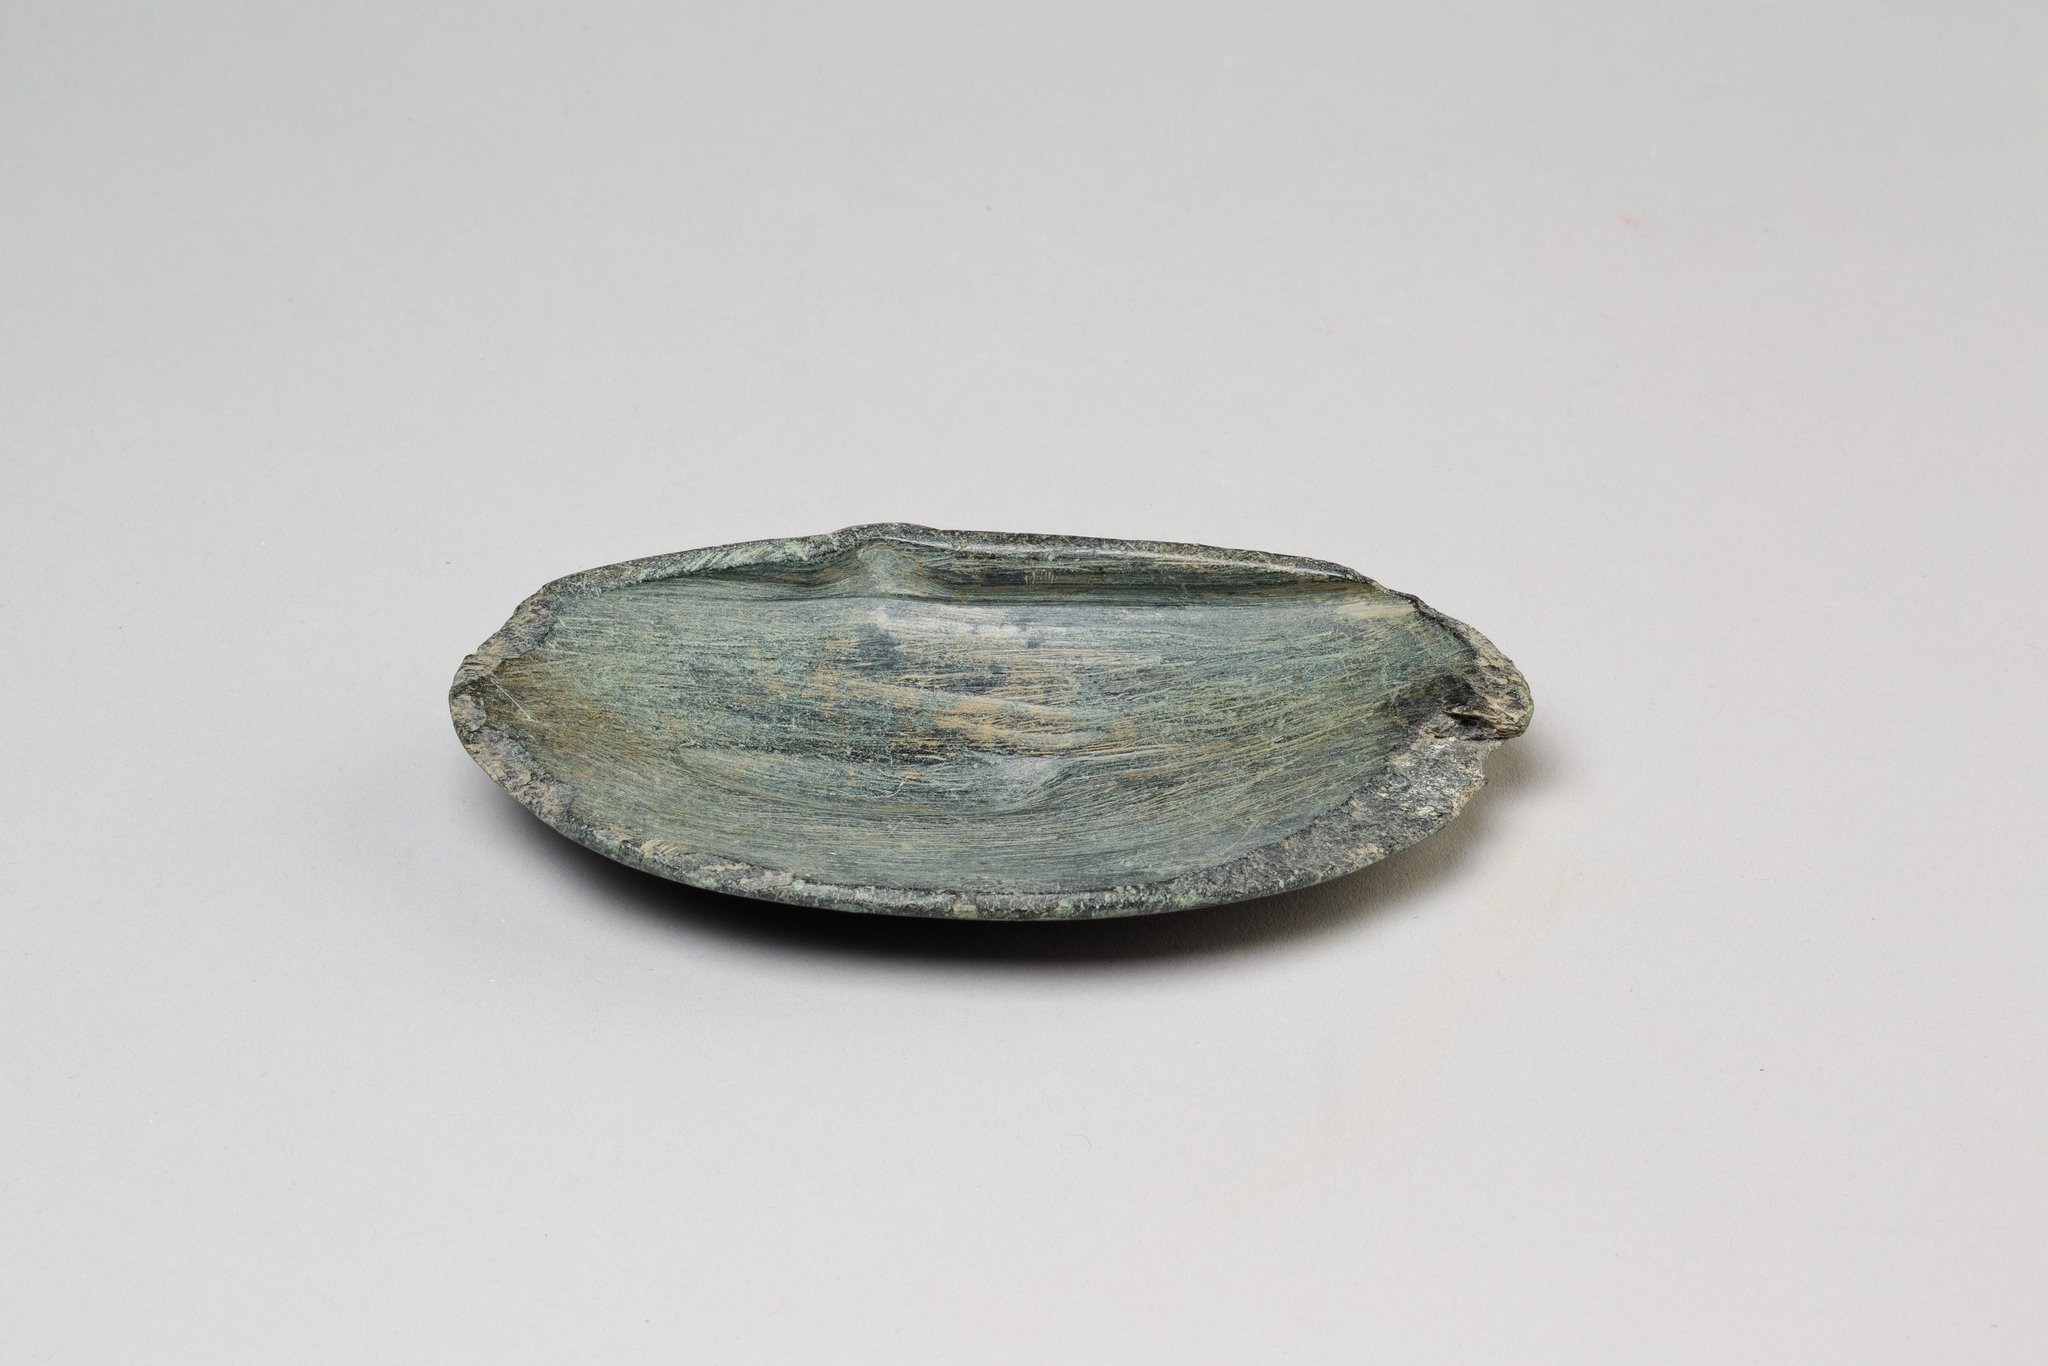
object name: scribe's paint dish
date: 1981-1640 BCE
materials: stone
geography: egypt